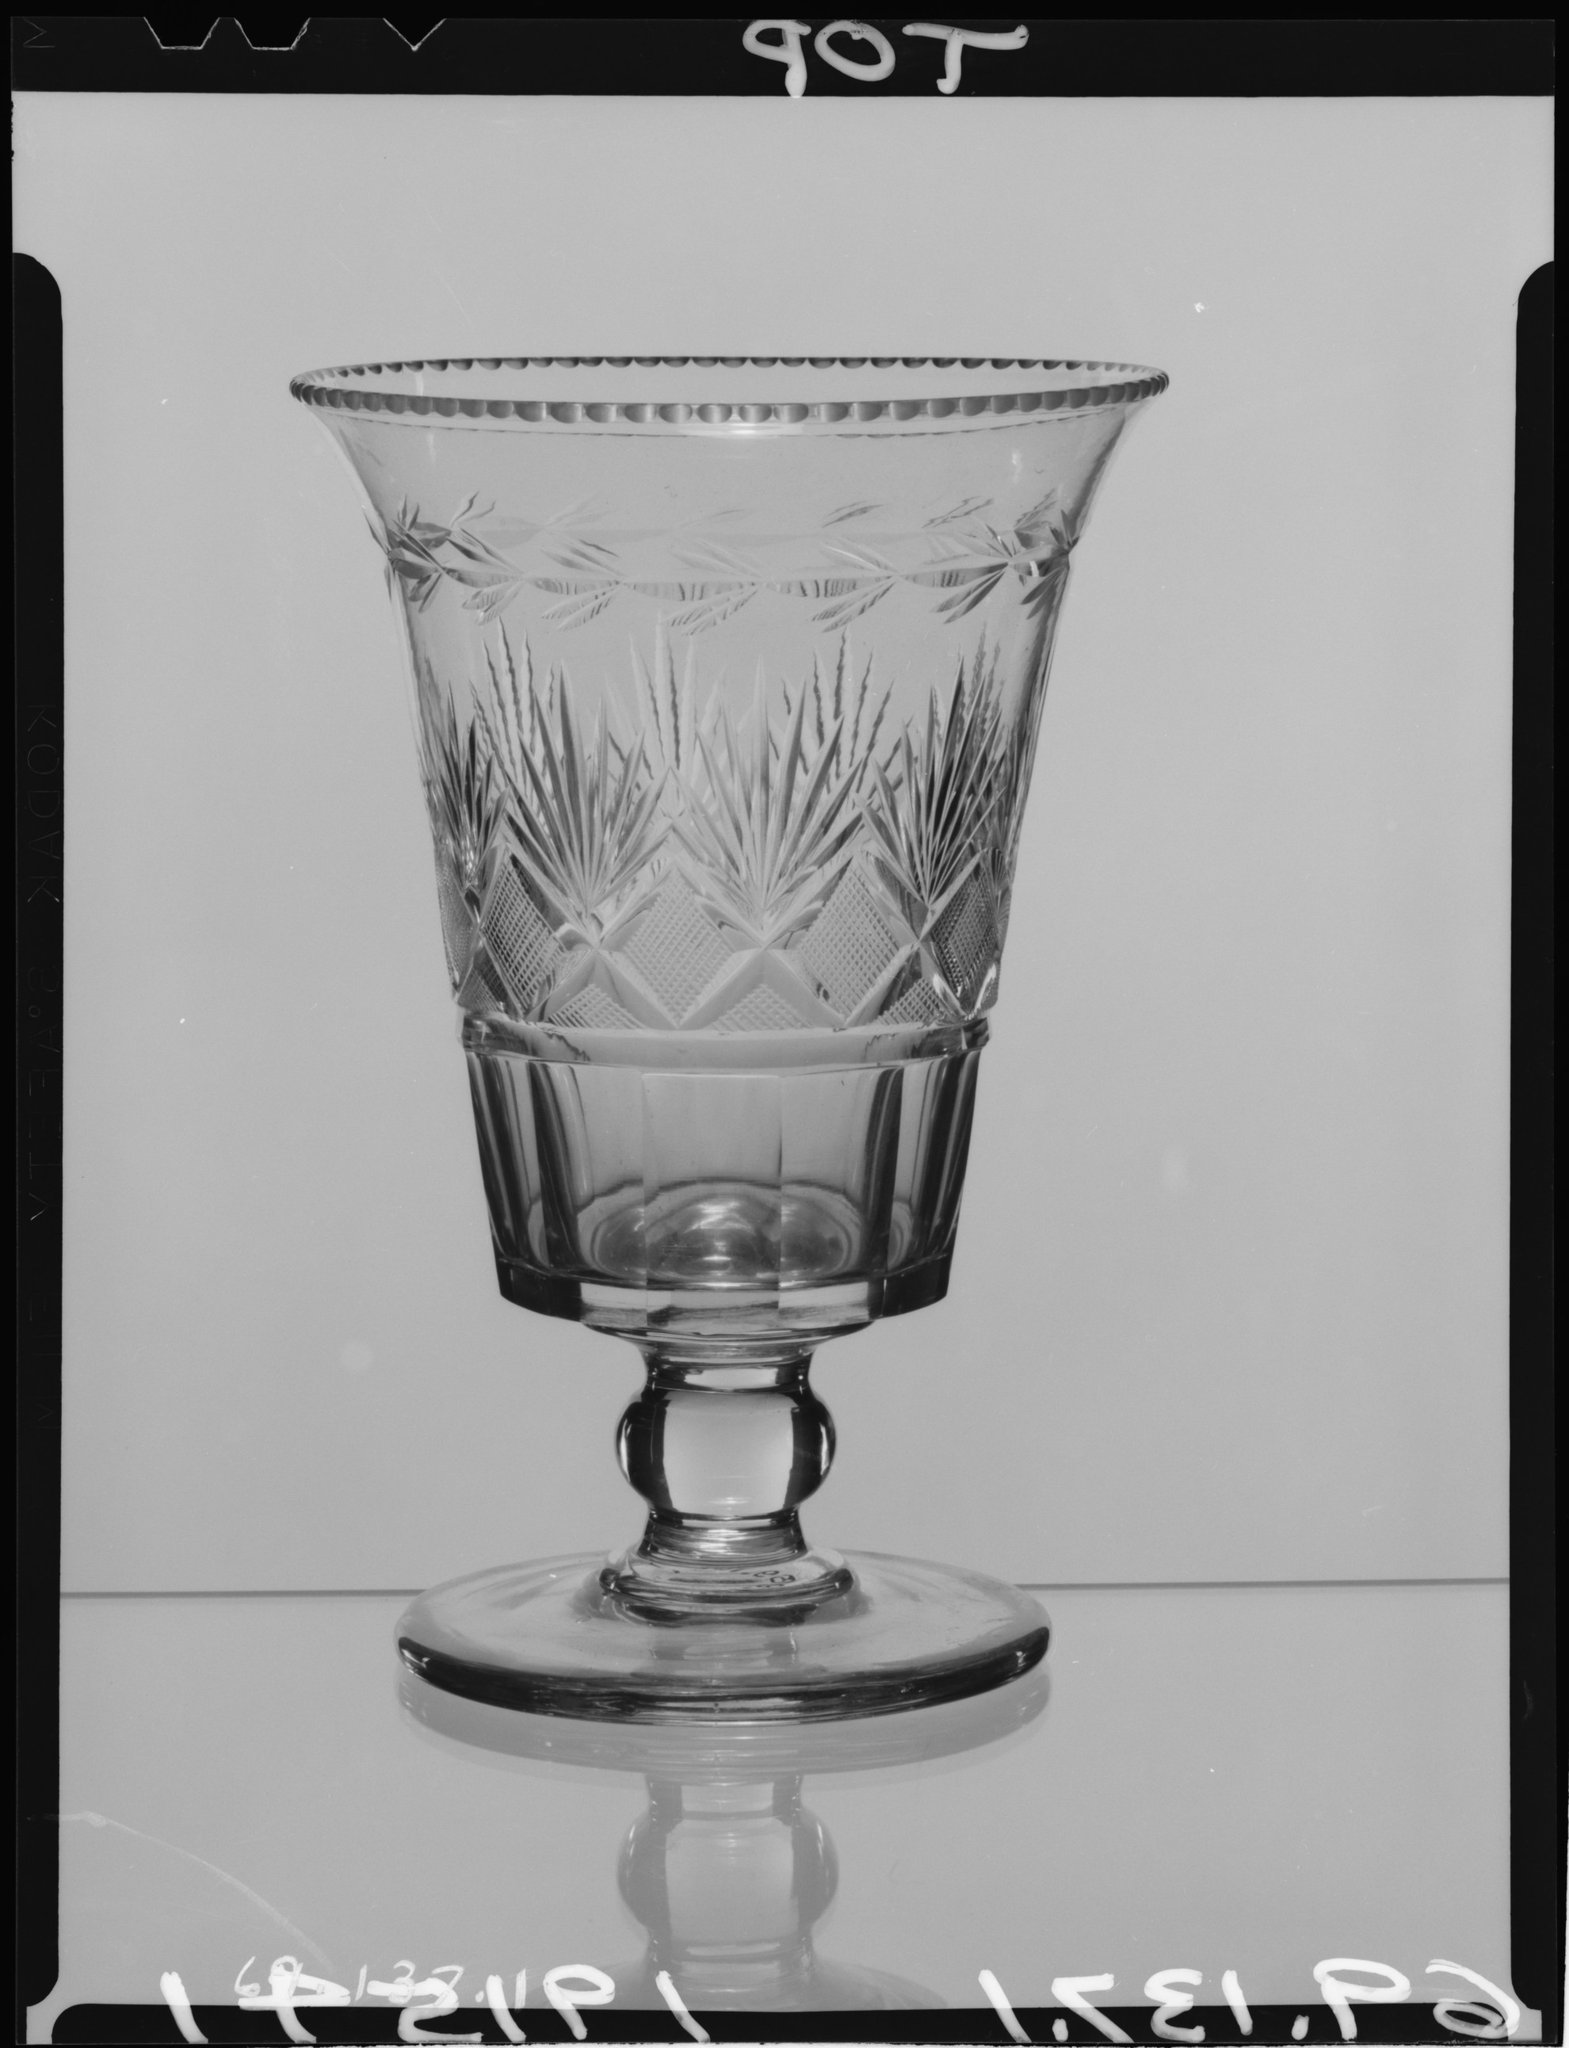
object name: celery vase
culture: american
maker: bakewell, page & bakewell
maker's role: maker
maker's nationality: american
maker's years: 1808-1882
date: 1825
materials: glass, lead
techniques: glassblowing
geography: united states